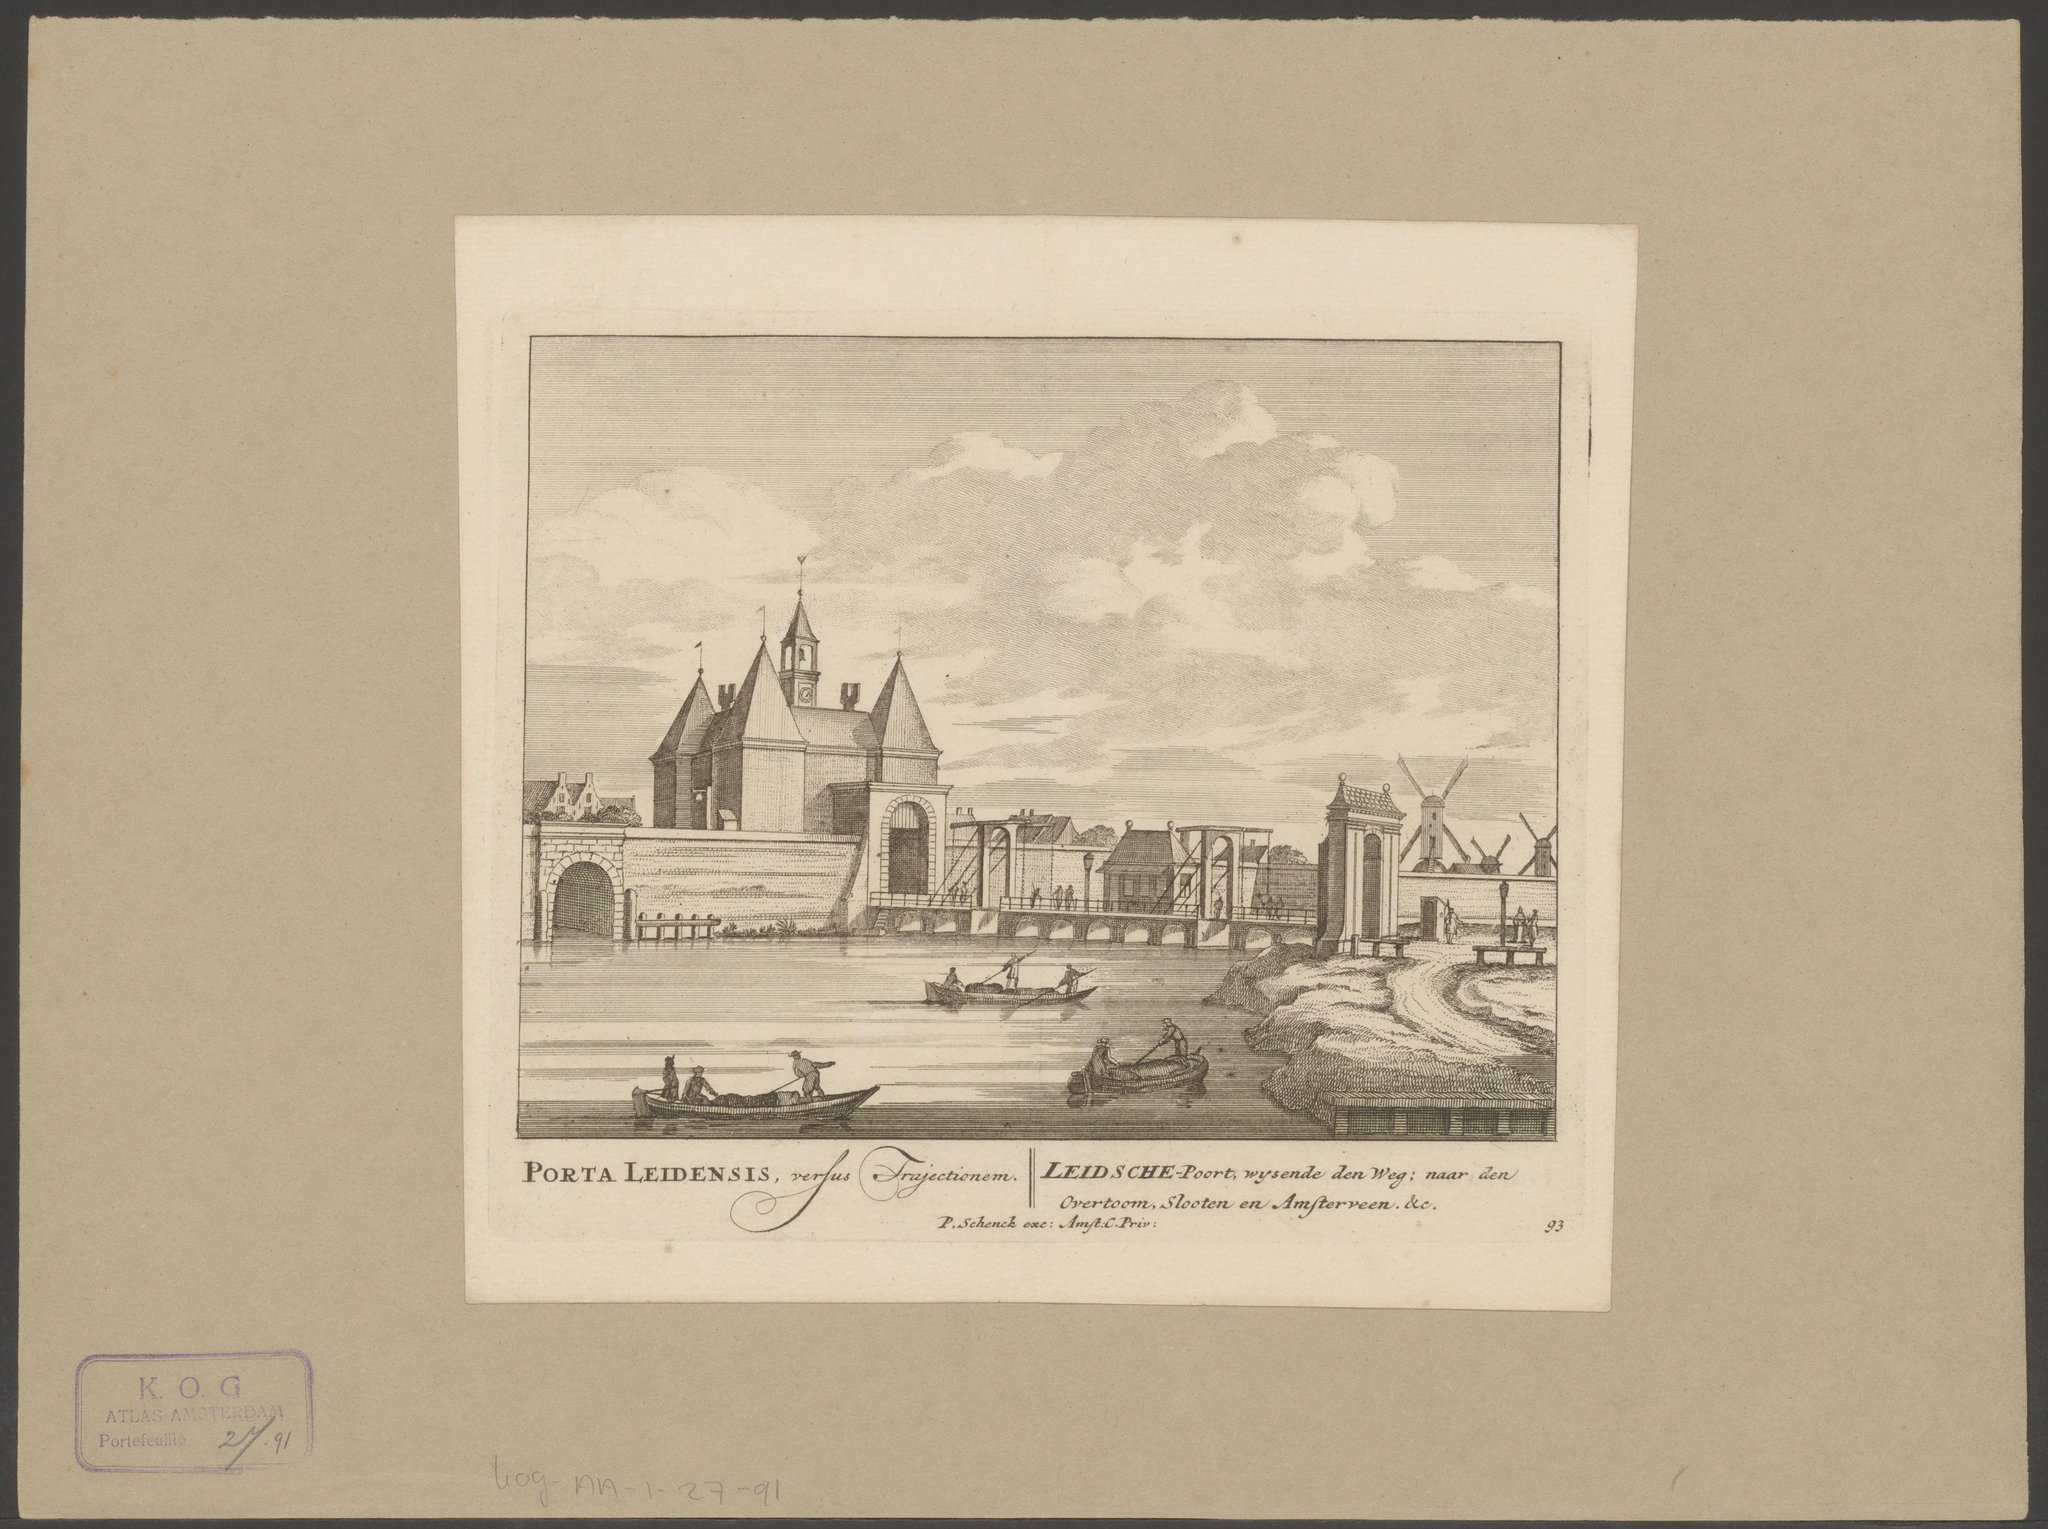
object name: print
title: Gezicht op de Leidsepoort te Amsterdam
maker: pieter schenk (i)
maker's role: print maker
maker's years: 1660-1711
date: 1675-1710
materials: paper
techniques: engraving, etching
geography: amsterdam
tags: rowing-boat, canoe, etc., bridge in city across river, canal, etc., city-gate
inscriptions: collector's mark: Lugt 1641b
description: Prent mogelijk uit: Schenk, Pieter (I). Den Hoog-Edelgeboren Heer C. de Jonge van Ellemeet, Heere van Ellemeet etc. etc. etc. Voor desen Ontfanger Generael vande Linie, Nu Raed ende Pensionaris der Stadt Rotterdam etc. etc. etc. word de Afbeeldinge der voornaamste Gebouwen van Amsterdam. Amsterdam: Barent Greve, 1710.